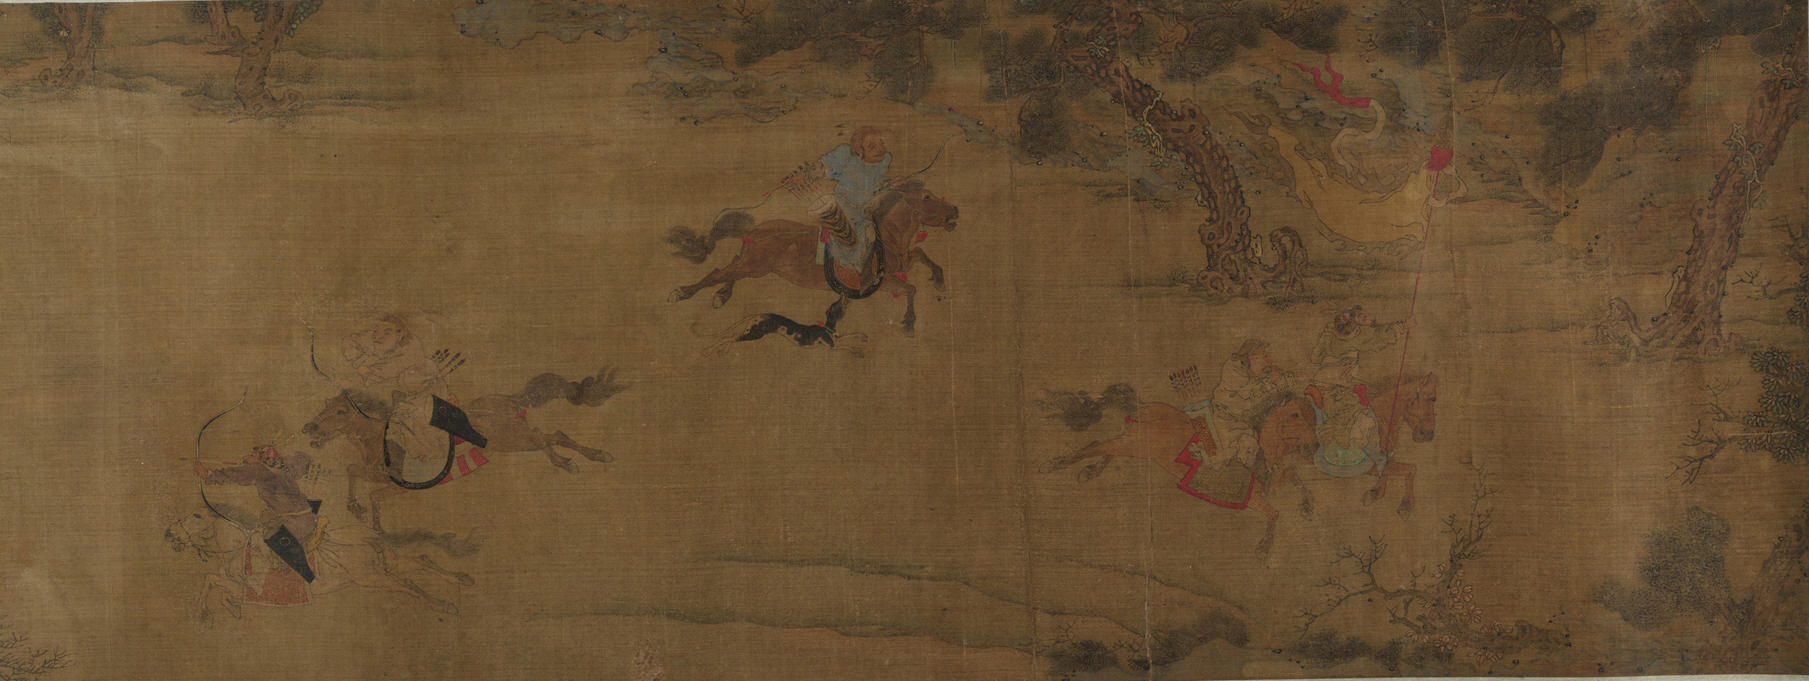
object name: handscroll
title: Tartar Huntsman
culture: chinese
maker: unidentified artist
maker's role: artist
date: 1530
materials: ink, silk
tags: bow and arrow,men,hunting,horses